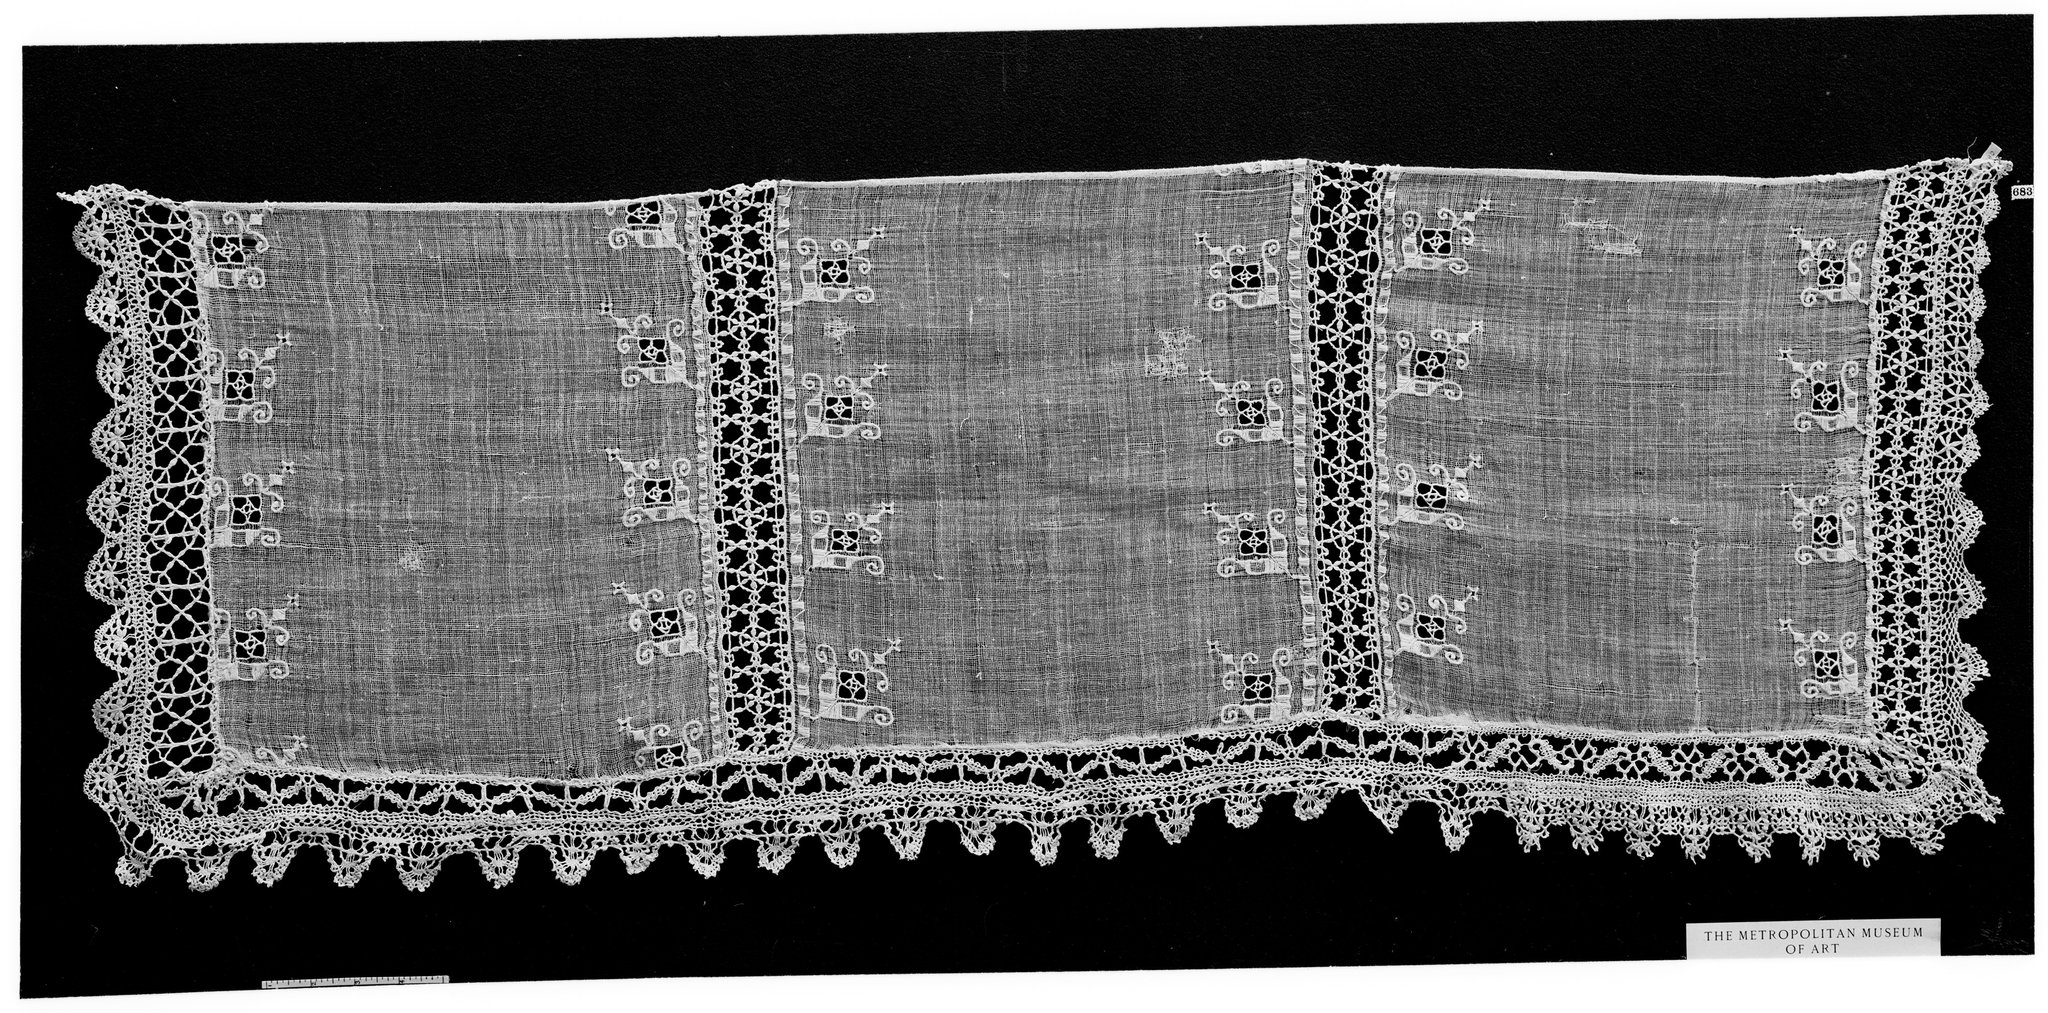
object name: altar frontal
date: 1600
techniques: lace